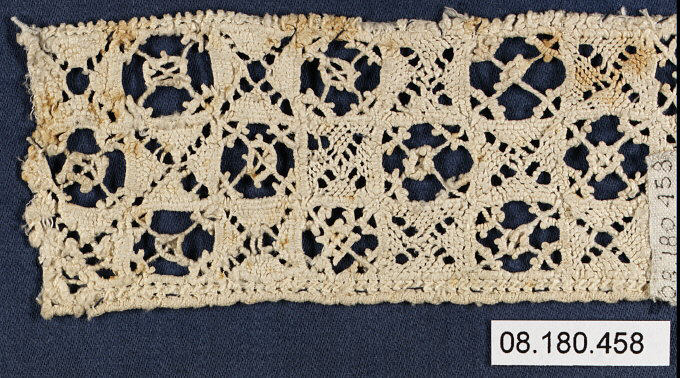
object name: fragment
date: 1601-1700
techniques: lace